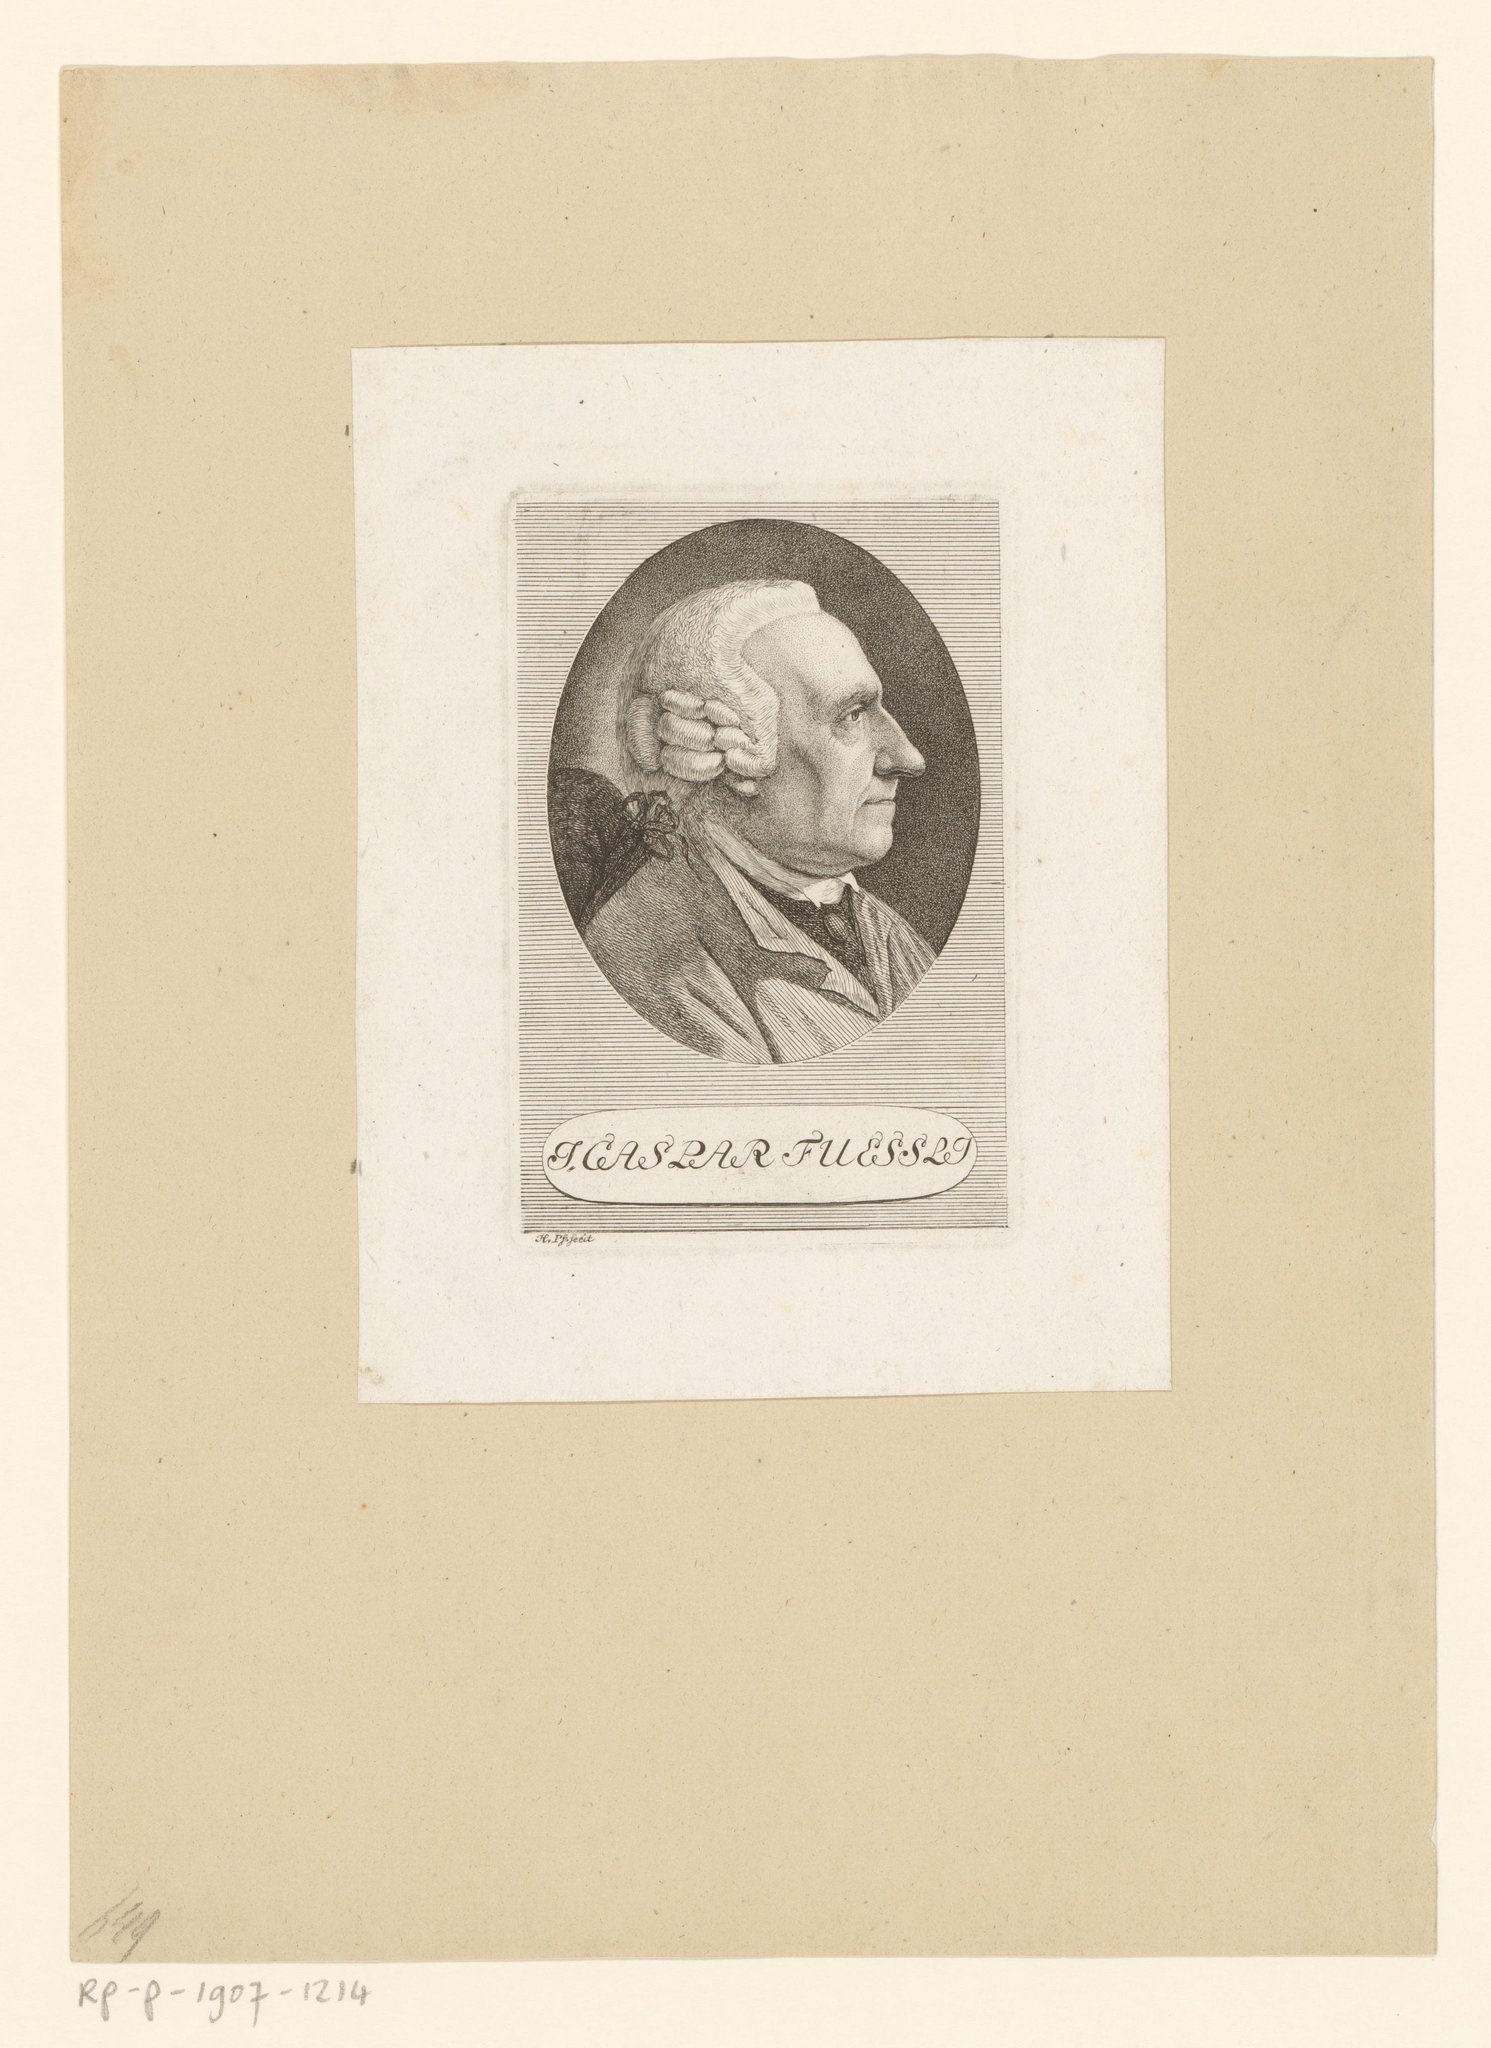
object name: print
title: Portret van Johann Caspar Füssli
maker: heinrich pfenninger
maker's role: print maker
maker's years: 1749-1815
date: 1759-1815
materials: paper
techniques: etching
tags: johann caspar füssli, historical persons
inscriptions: collector's mark: Lugt 2228